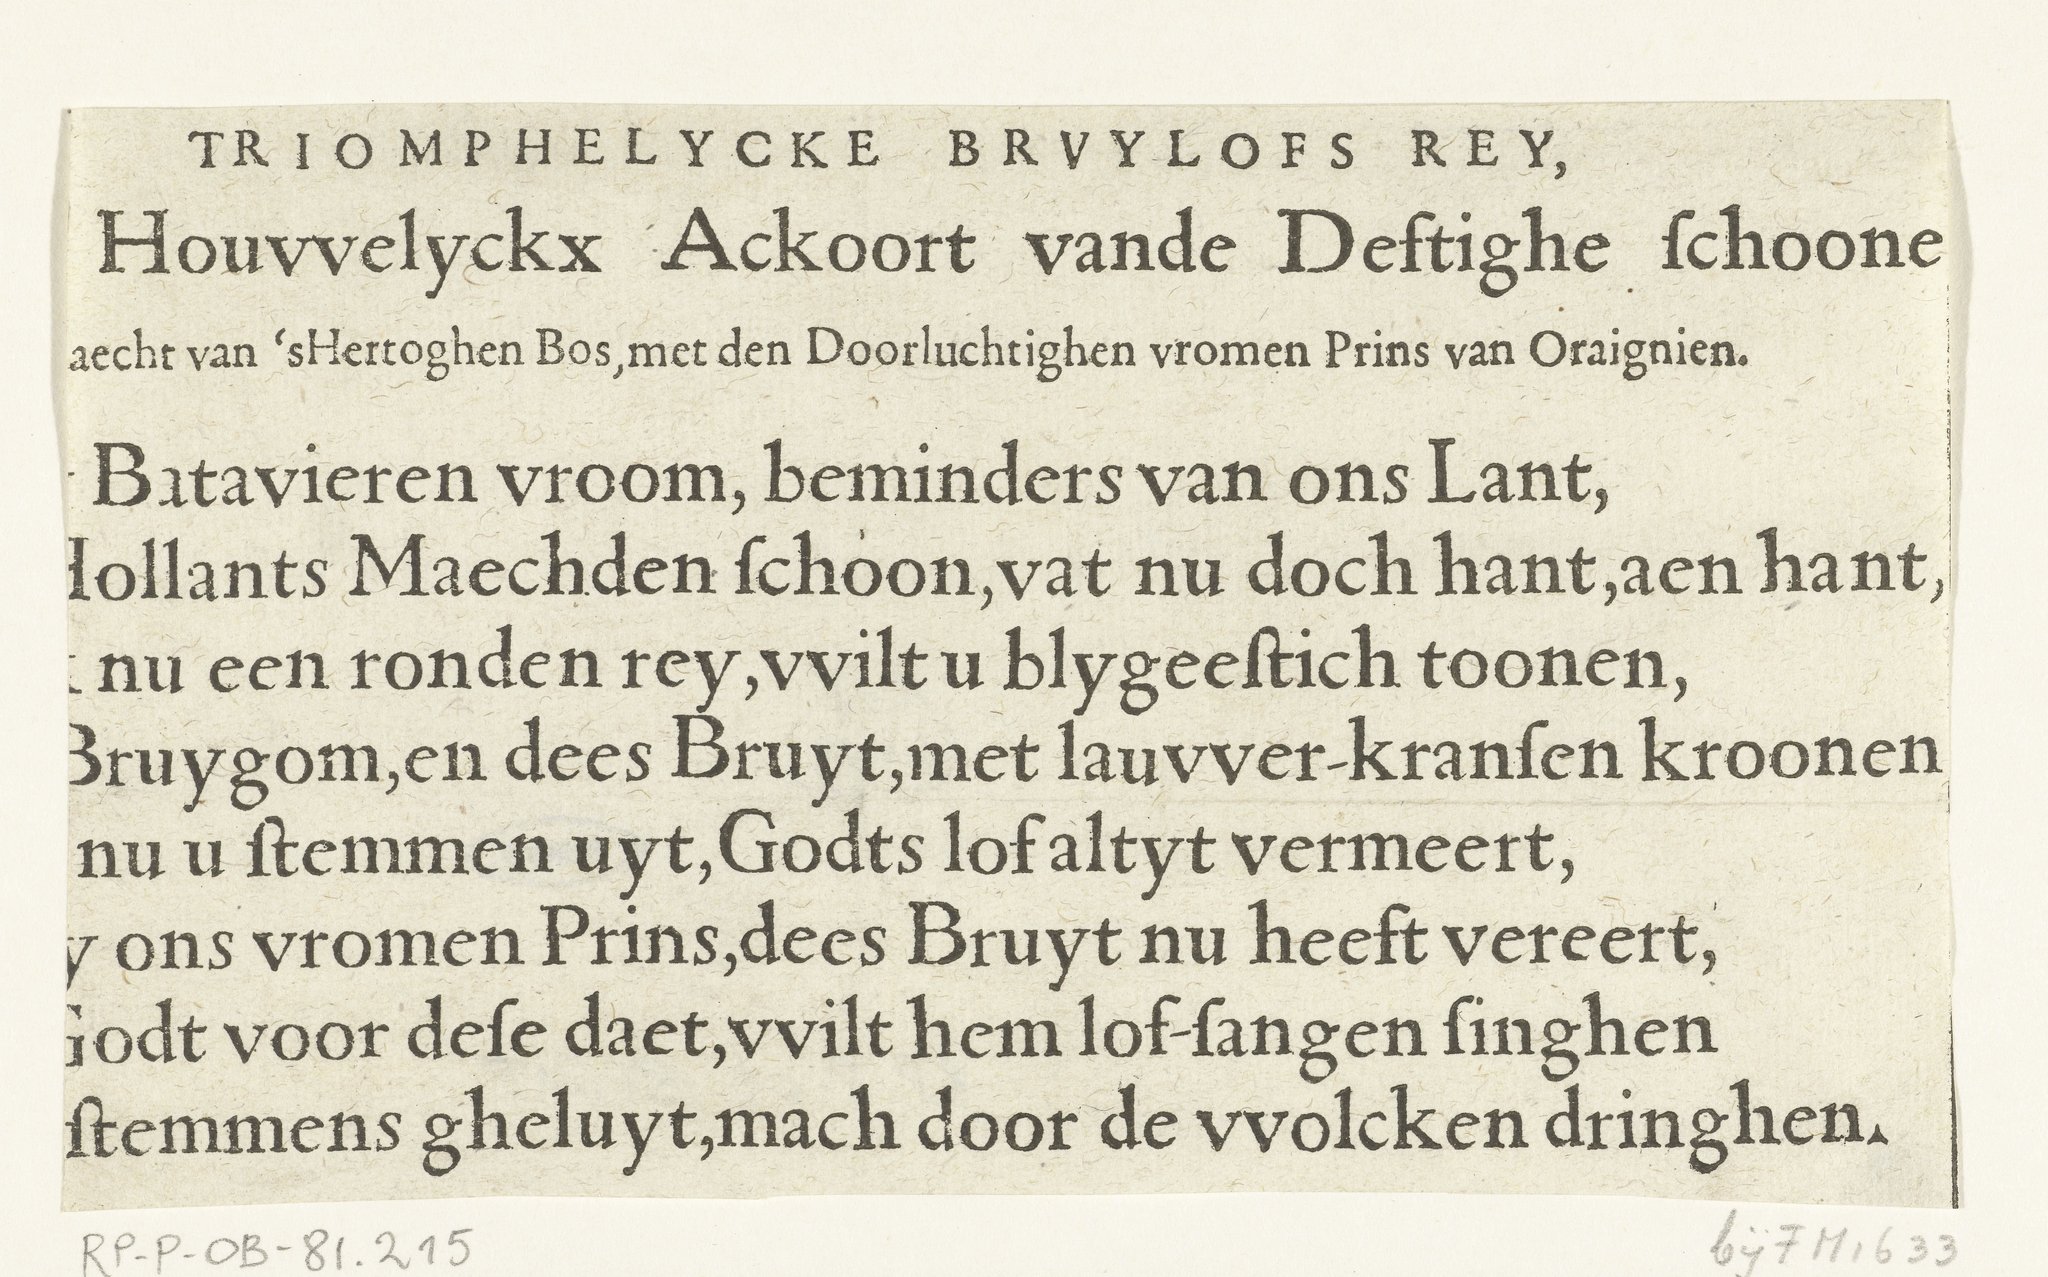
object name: text sheet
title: Triomphelycke Bruylofs Rey, Houwelyckx Ackoort vande Deftighe schoone [m]aecht van 'sHertoghen Bos, met den Doorluchtighen vromen Prins van Oraignien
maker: Anonymous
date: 1629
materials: paper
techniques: letterpress printing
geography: northern netherlands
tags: the hague, frederick henry (prince of orange), den bosch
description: Vers ter ere van de verovering van 's-Hertogenbosch door Frederik Hendrik op 17 september 1629. Vers van 8 regels in het Nederlands.